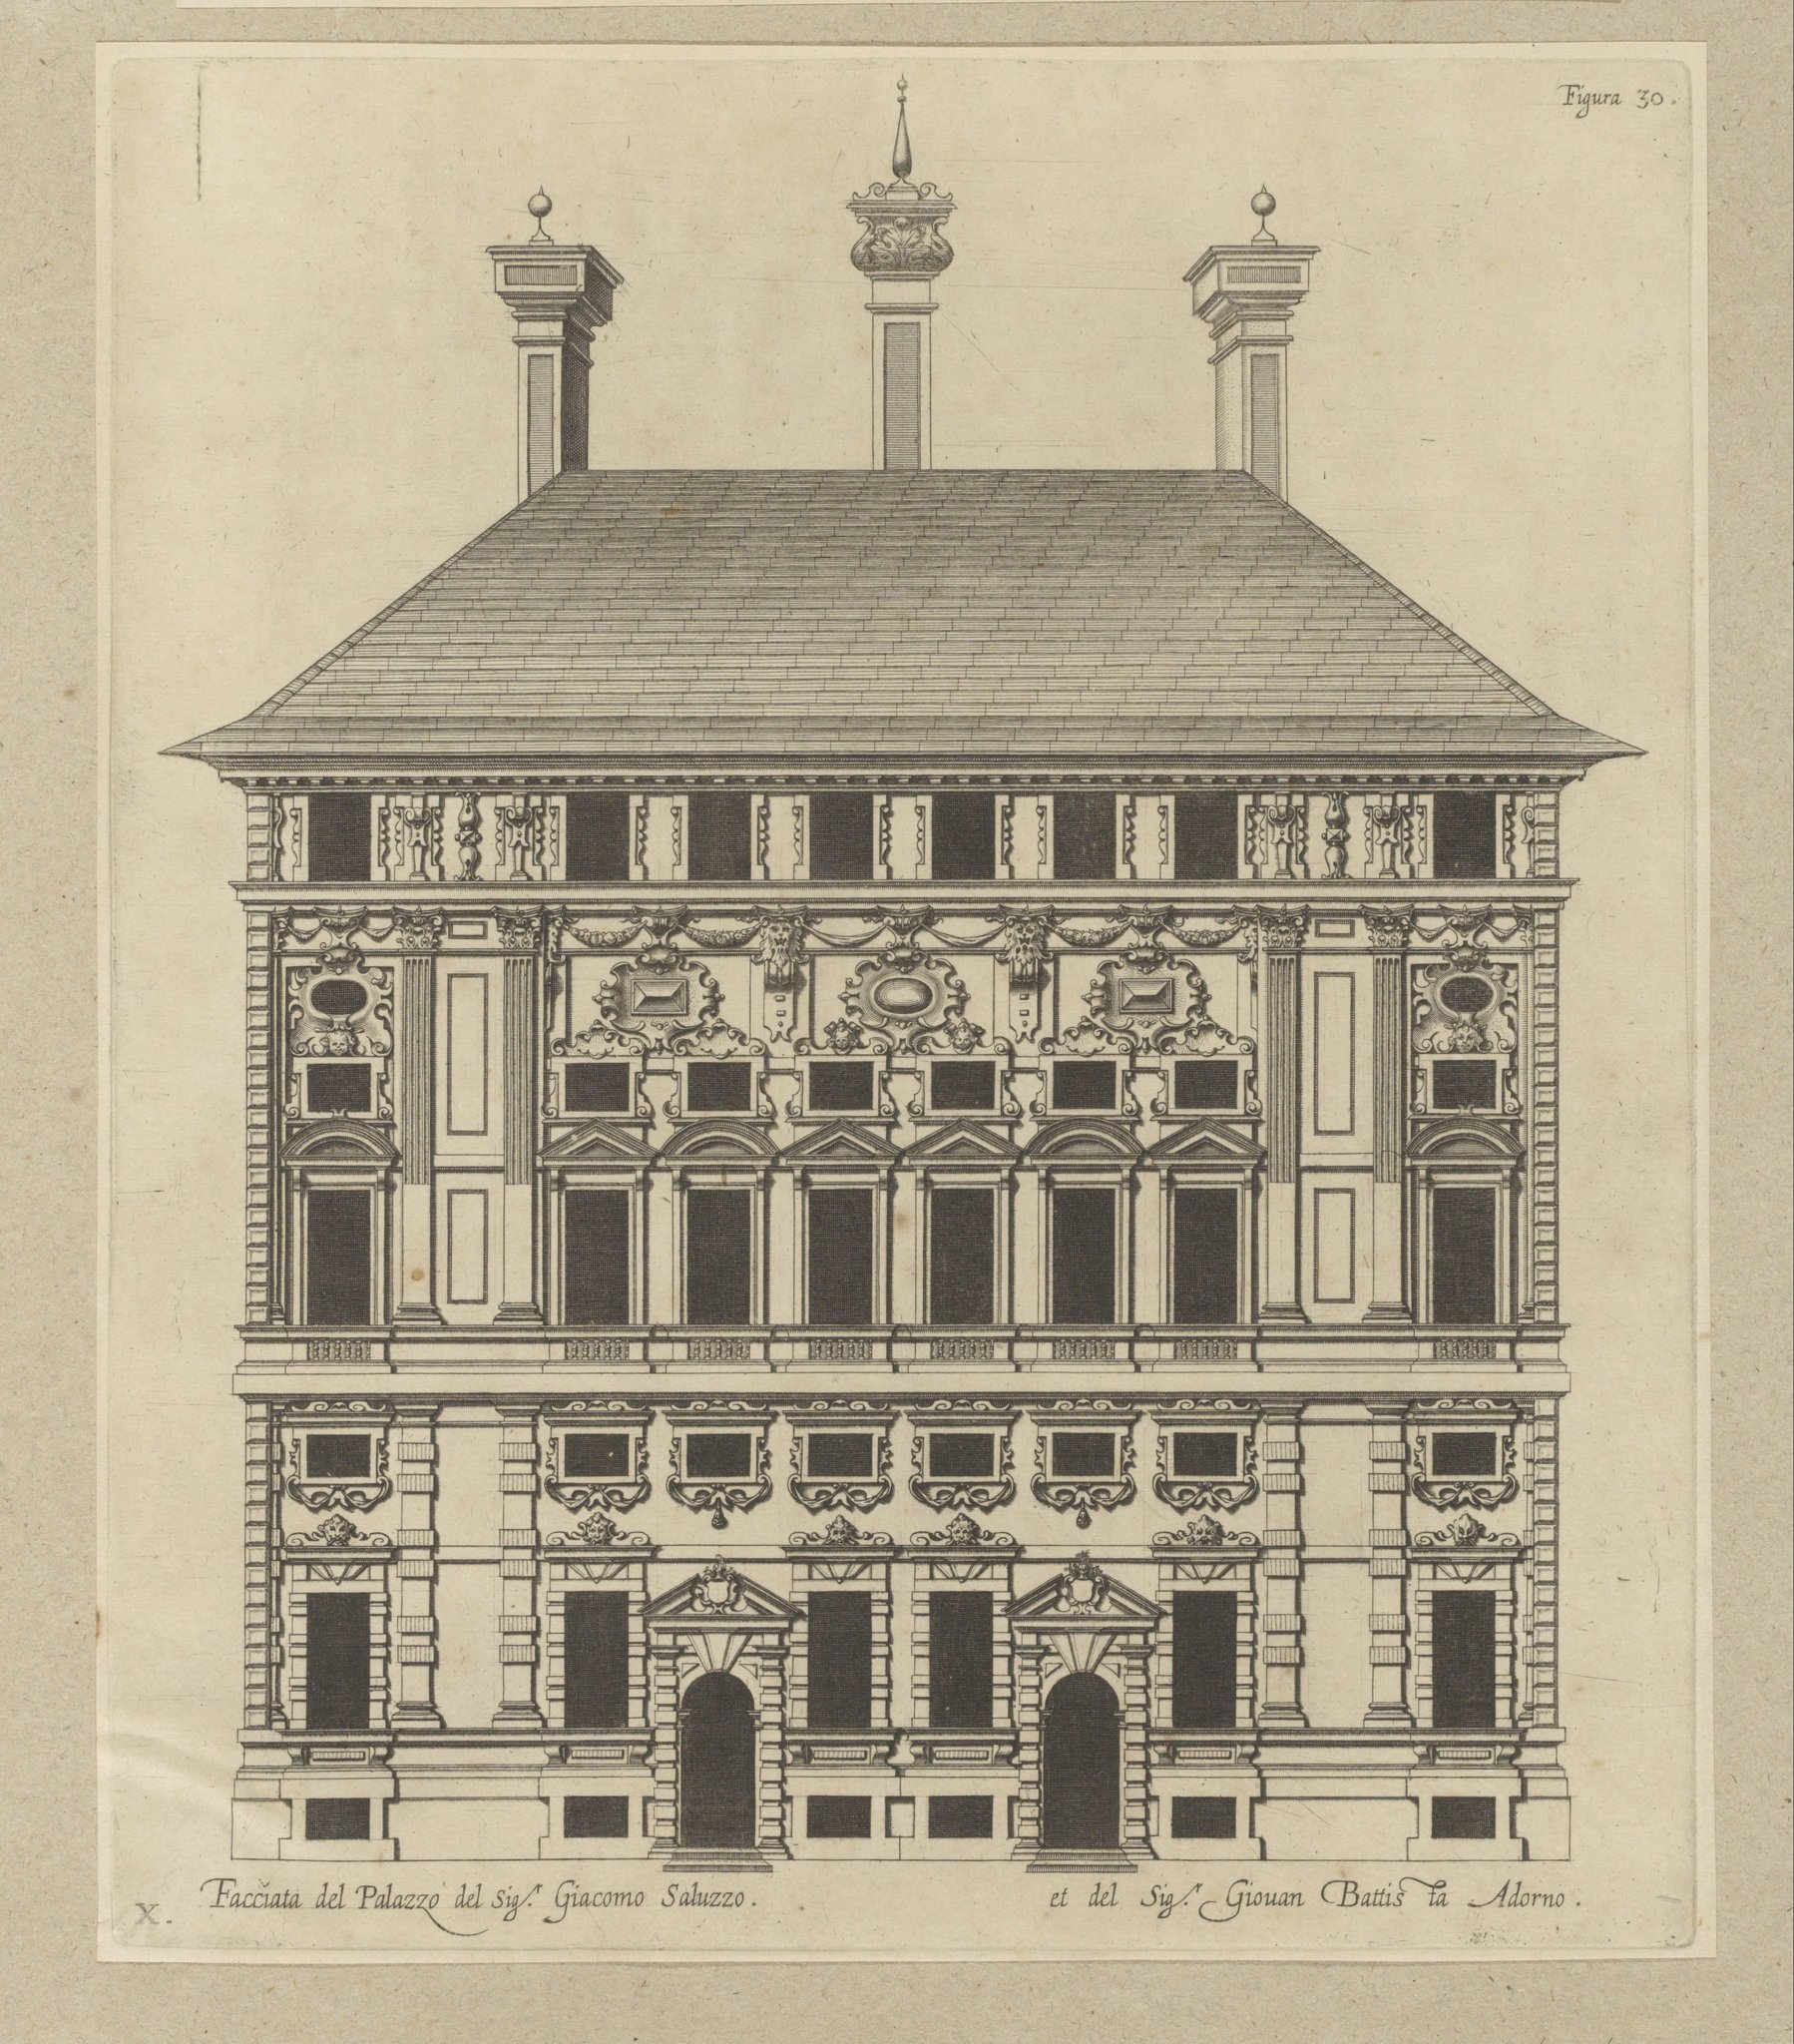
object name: album leaf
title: Opstand van de façade van het Palazzo Cattaneo-Adorno te Genua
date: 1622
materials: paper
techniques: engraving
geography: antwerp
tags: hôtel, i.e. small palace in city, façade (of house or building), exterior ~ architectural design or model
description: Deze prent maakt deel uit van een album.